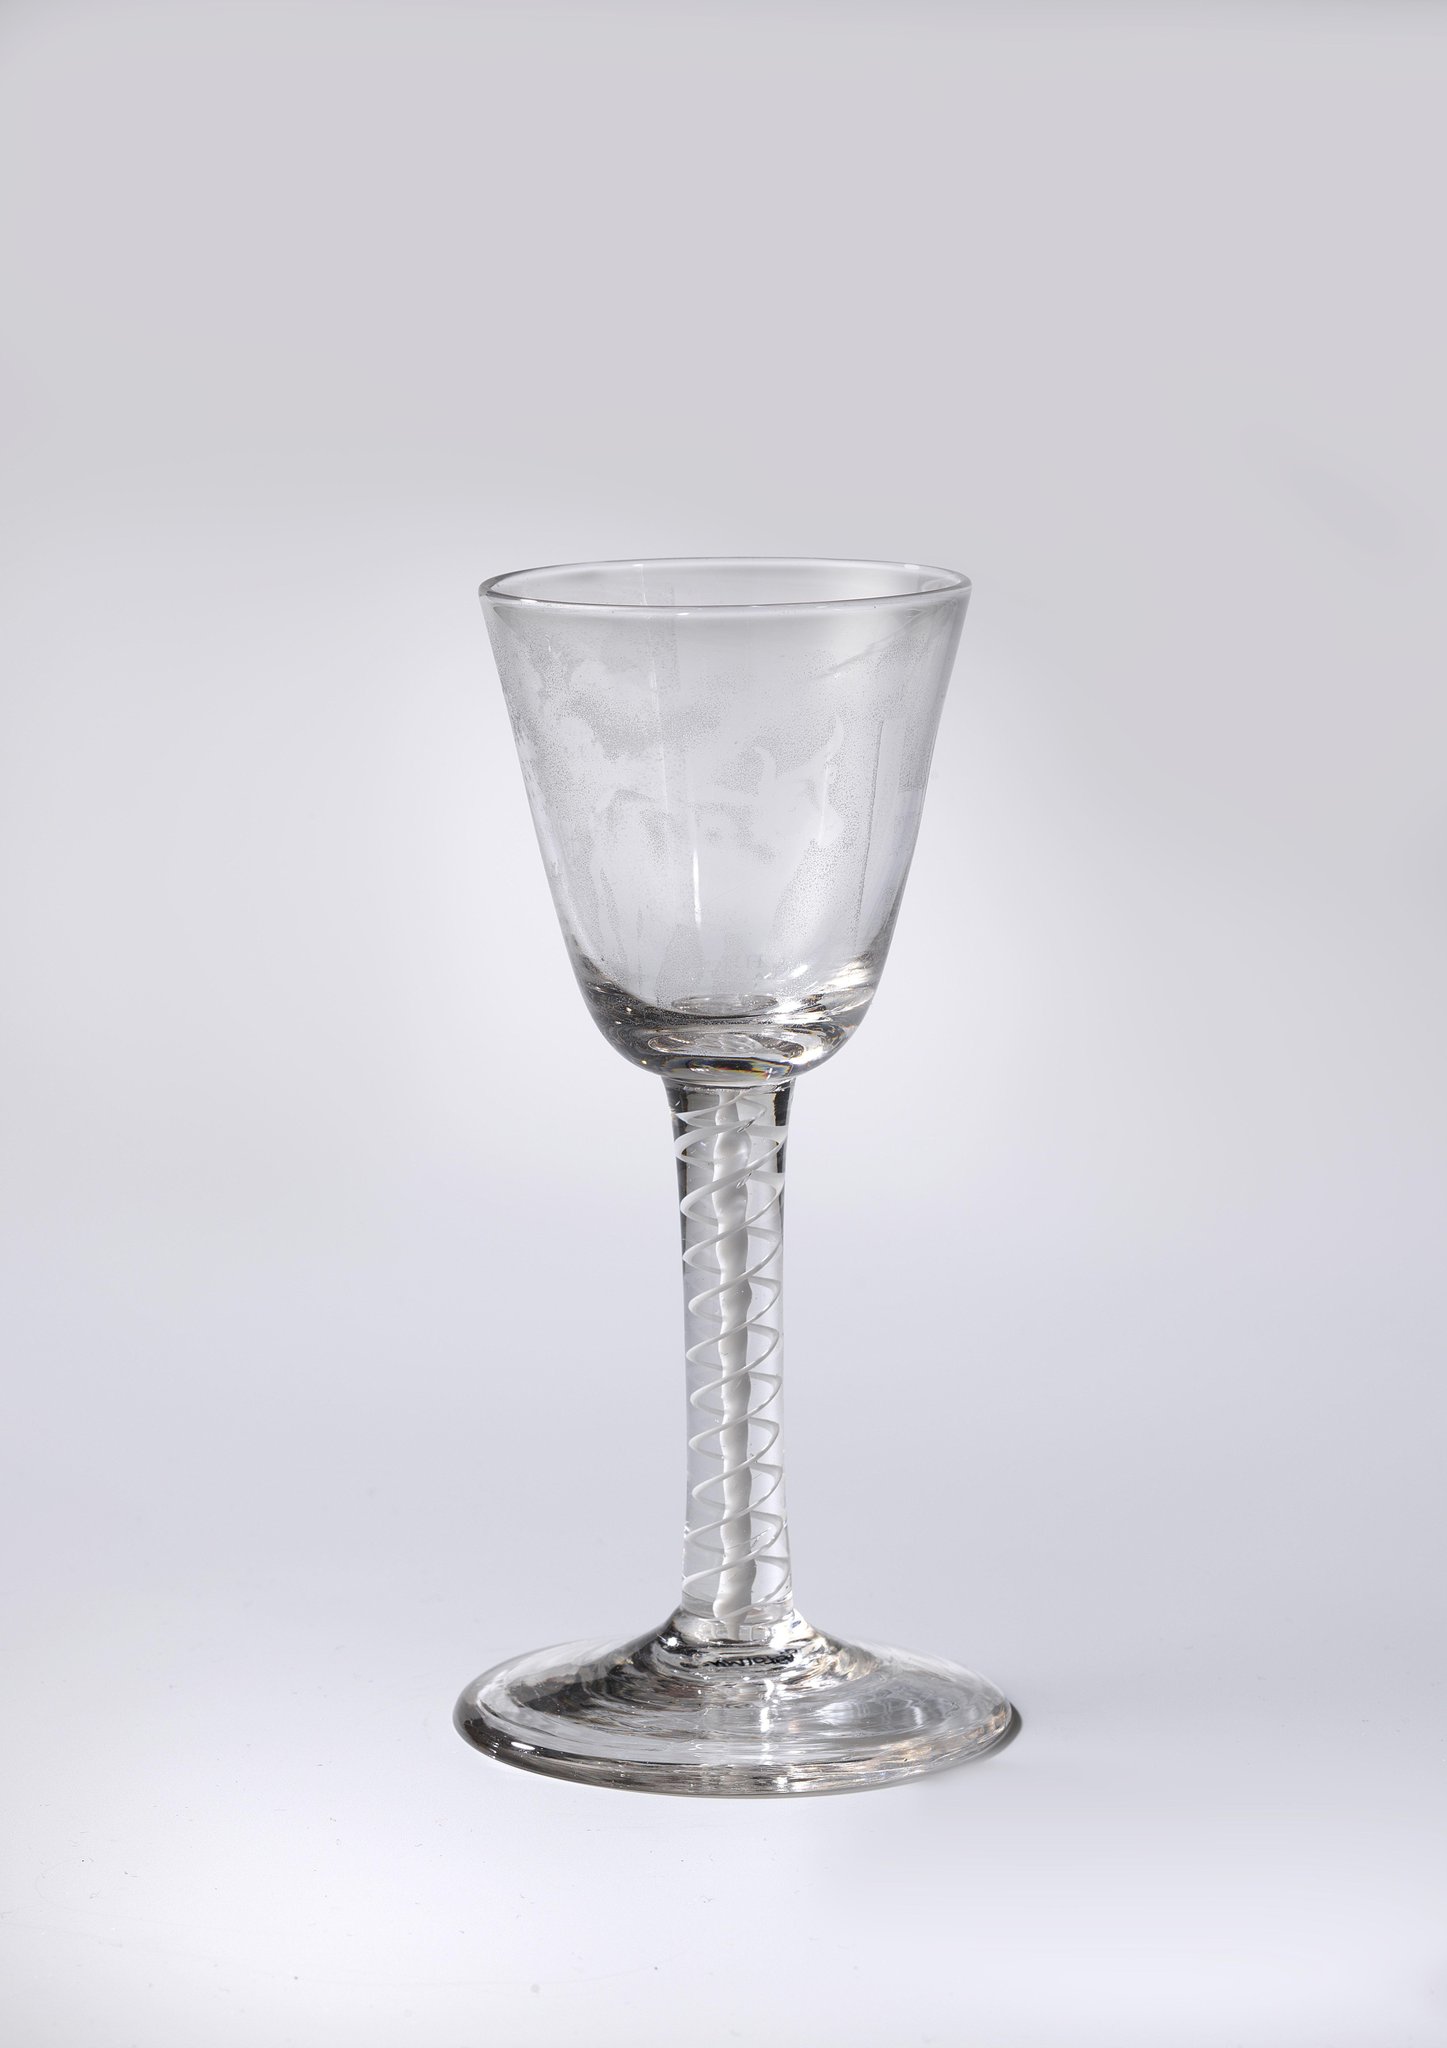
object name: goblet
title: Slingerglas met een voorstelling van een stier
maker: g.h. hoolaart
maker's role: glasgraveur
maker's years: 1731-1816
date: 1775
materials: glass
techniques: glassblowing, engraving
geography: dordrecht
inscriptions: signature: ‘G H Hoo / LAART / 1775’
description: Bull at a gate, 1775. A.J. Enschedé bequest, 1896.